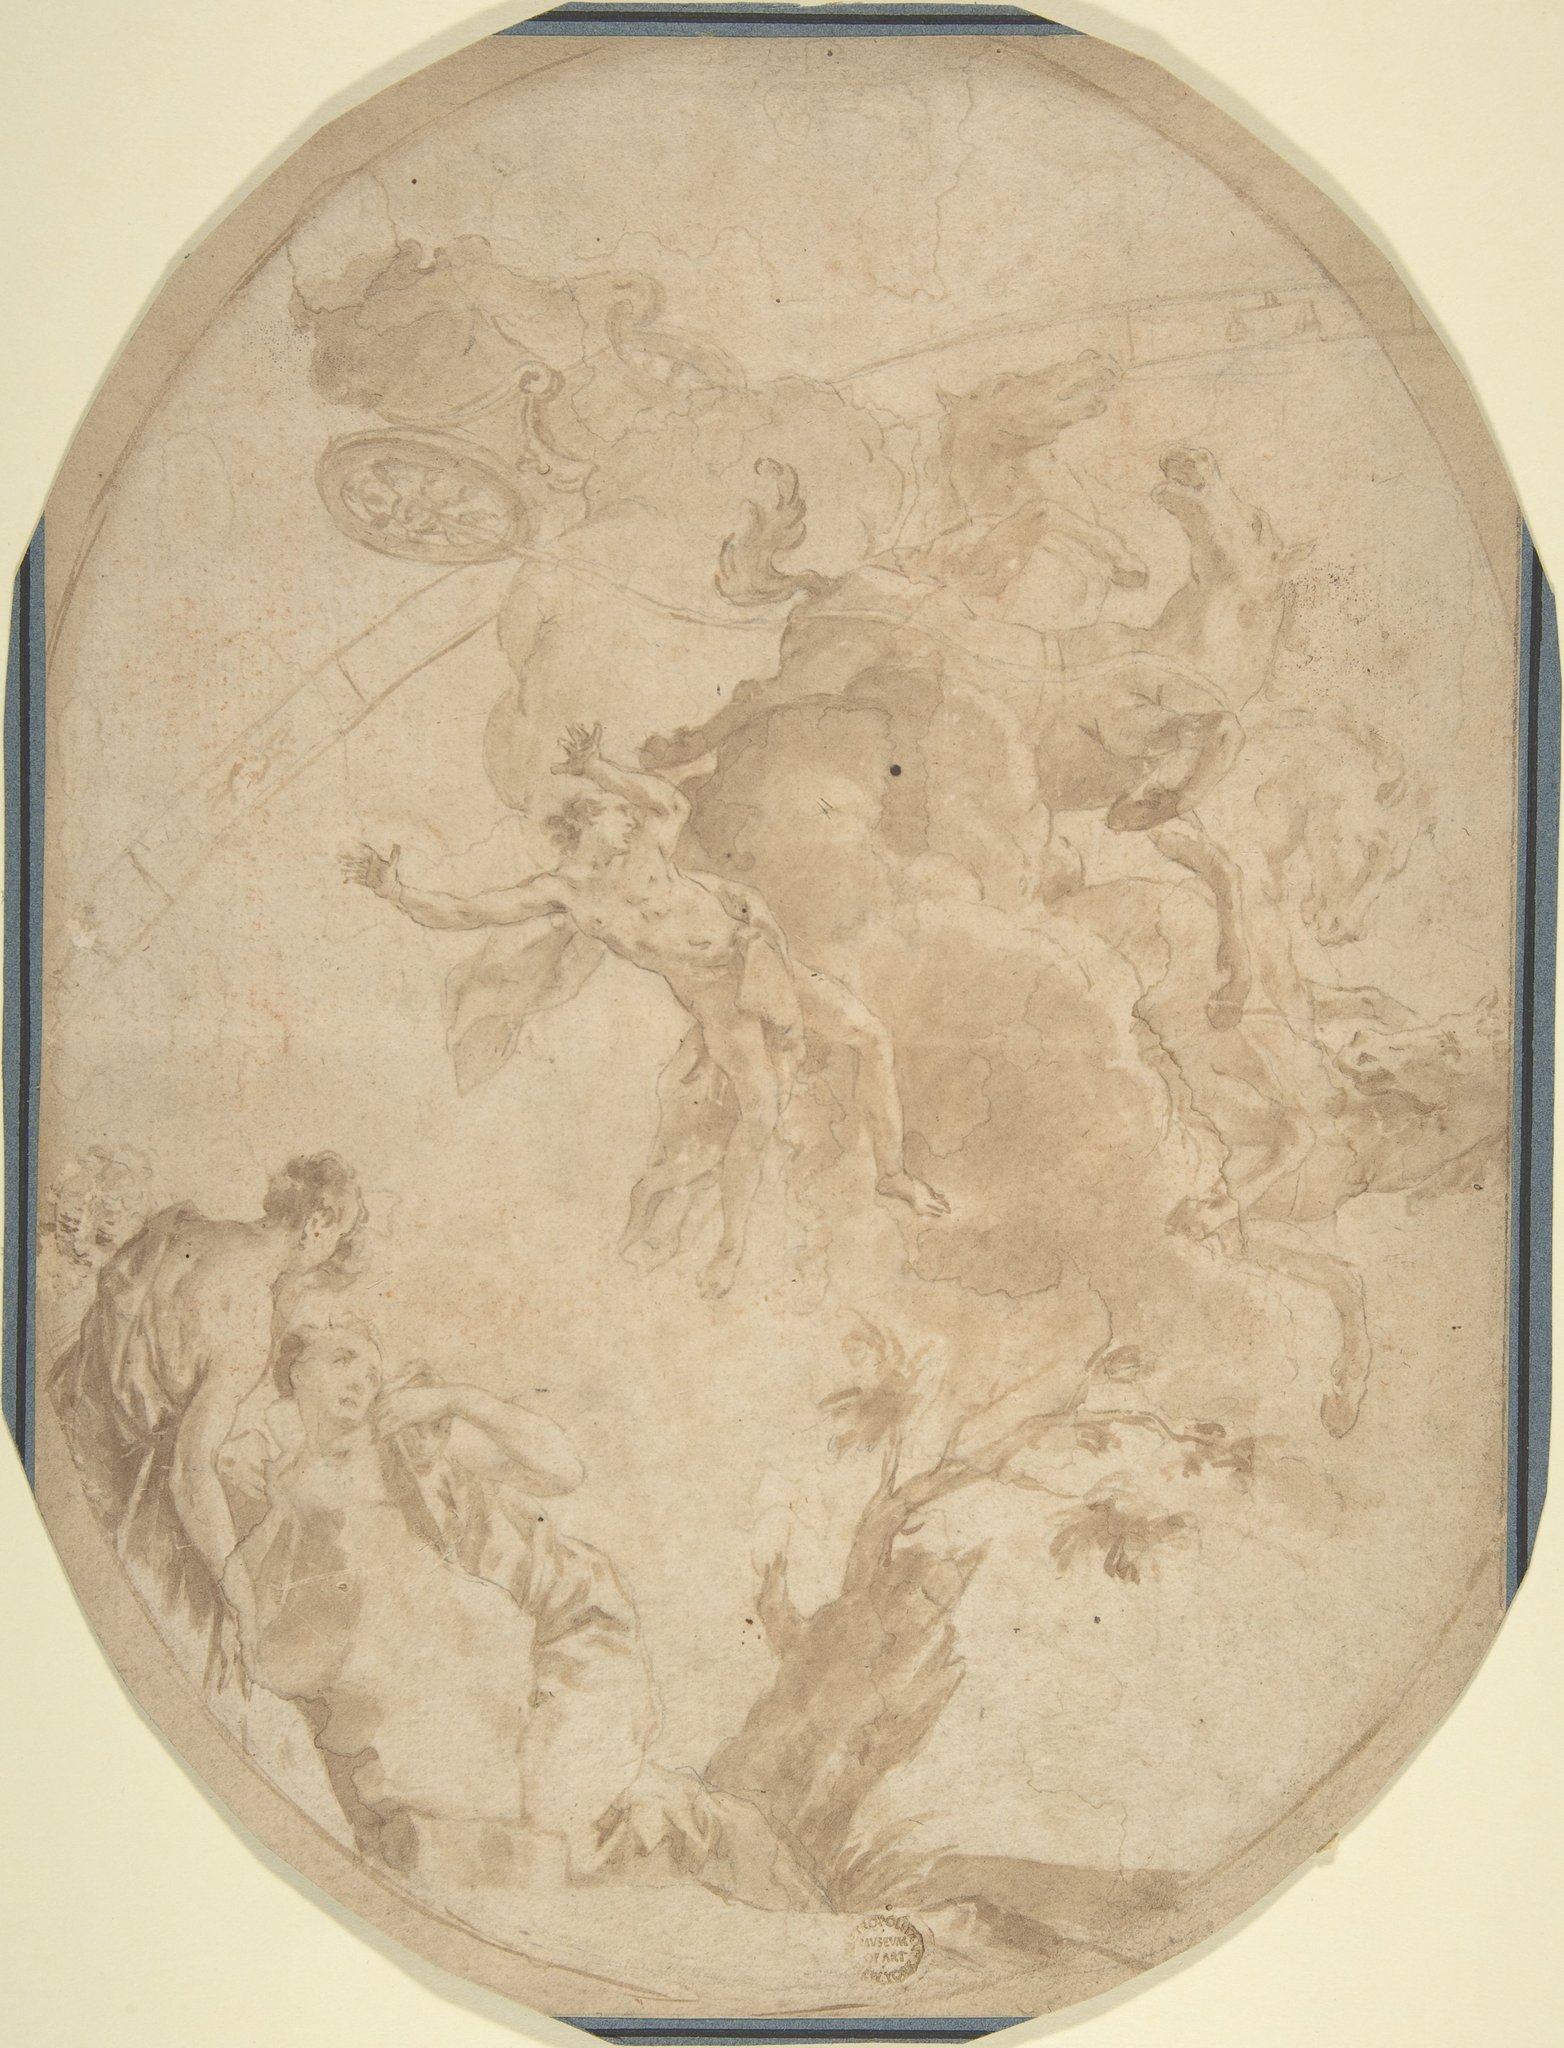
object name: drawing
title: Fall of Phaeton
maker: anonymous, italian, roman-bolognese, 17th century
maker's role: artist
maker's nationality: italian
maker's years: 1600-1700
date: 1601-1700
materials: chalk, ink, paper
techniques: brush, wash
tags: men,horses,carriages